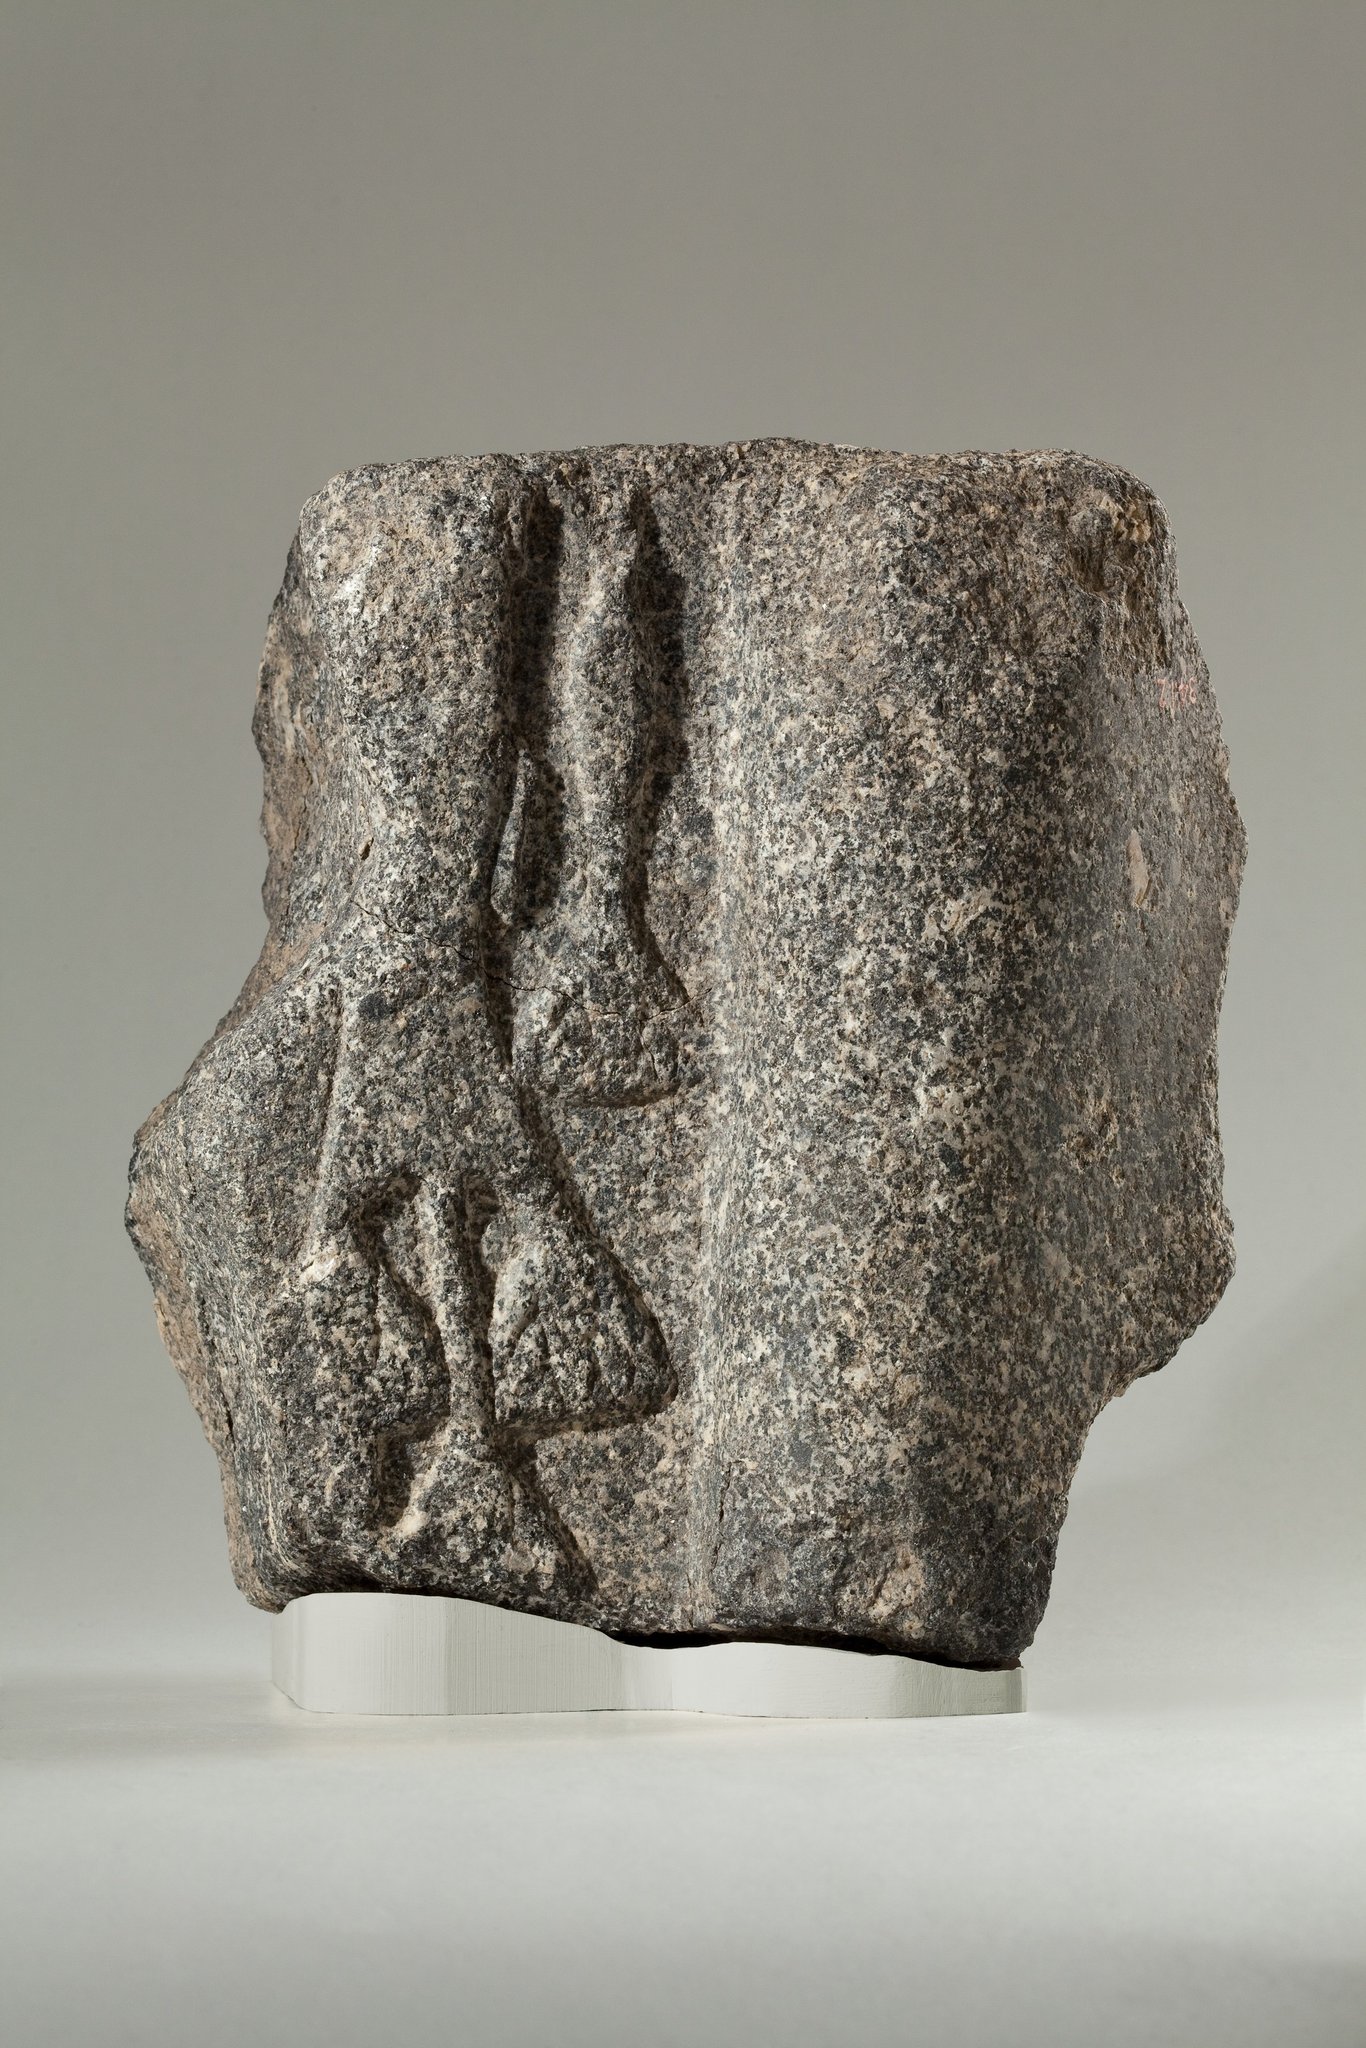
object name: statue fragment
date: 1981-1640 BCE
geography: egypt